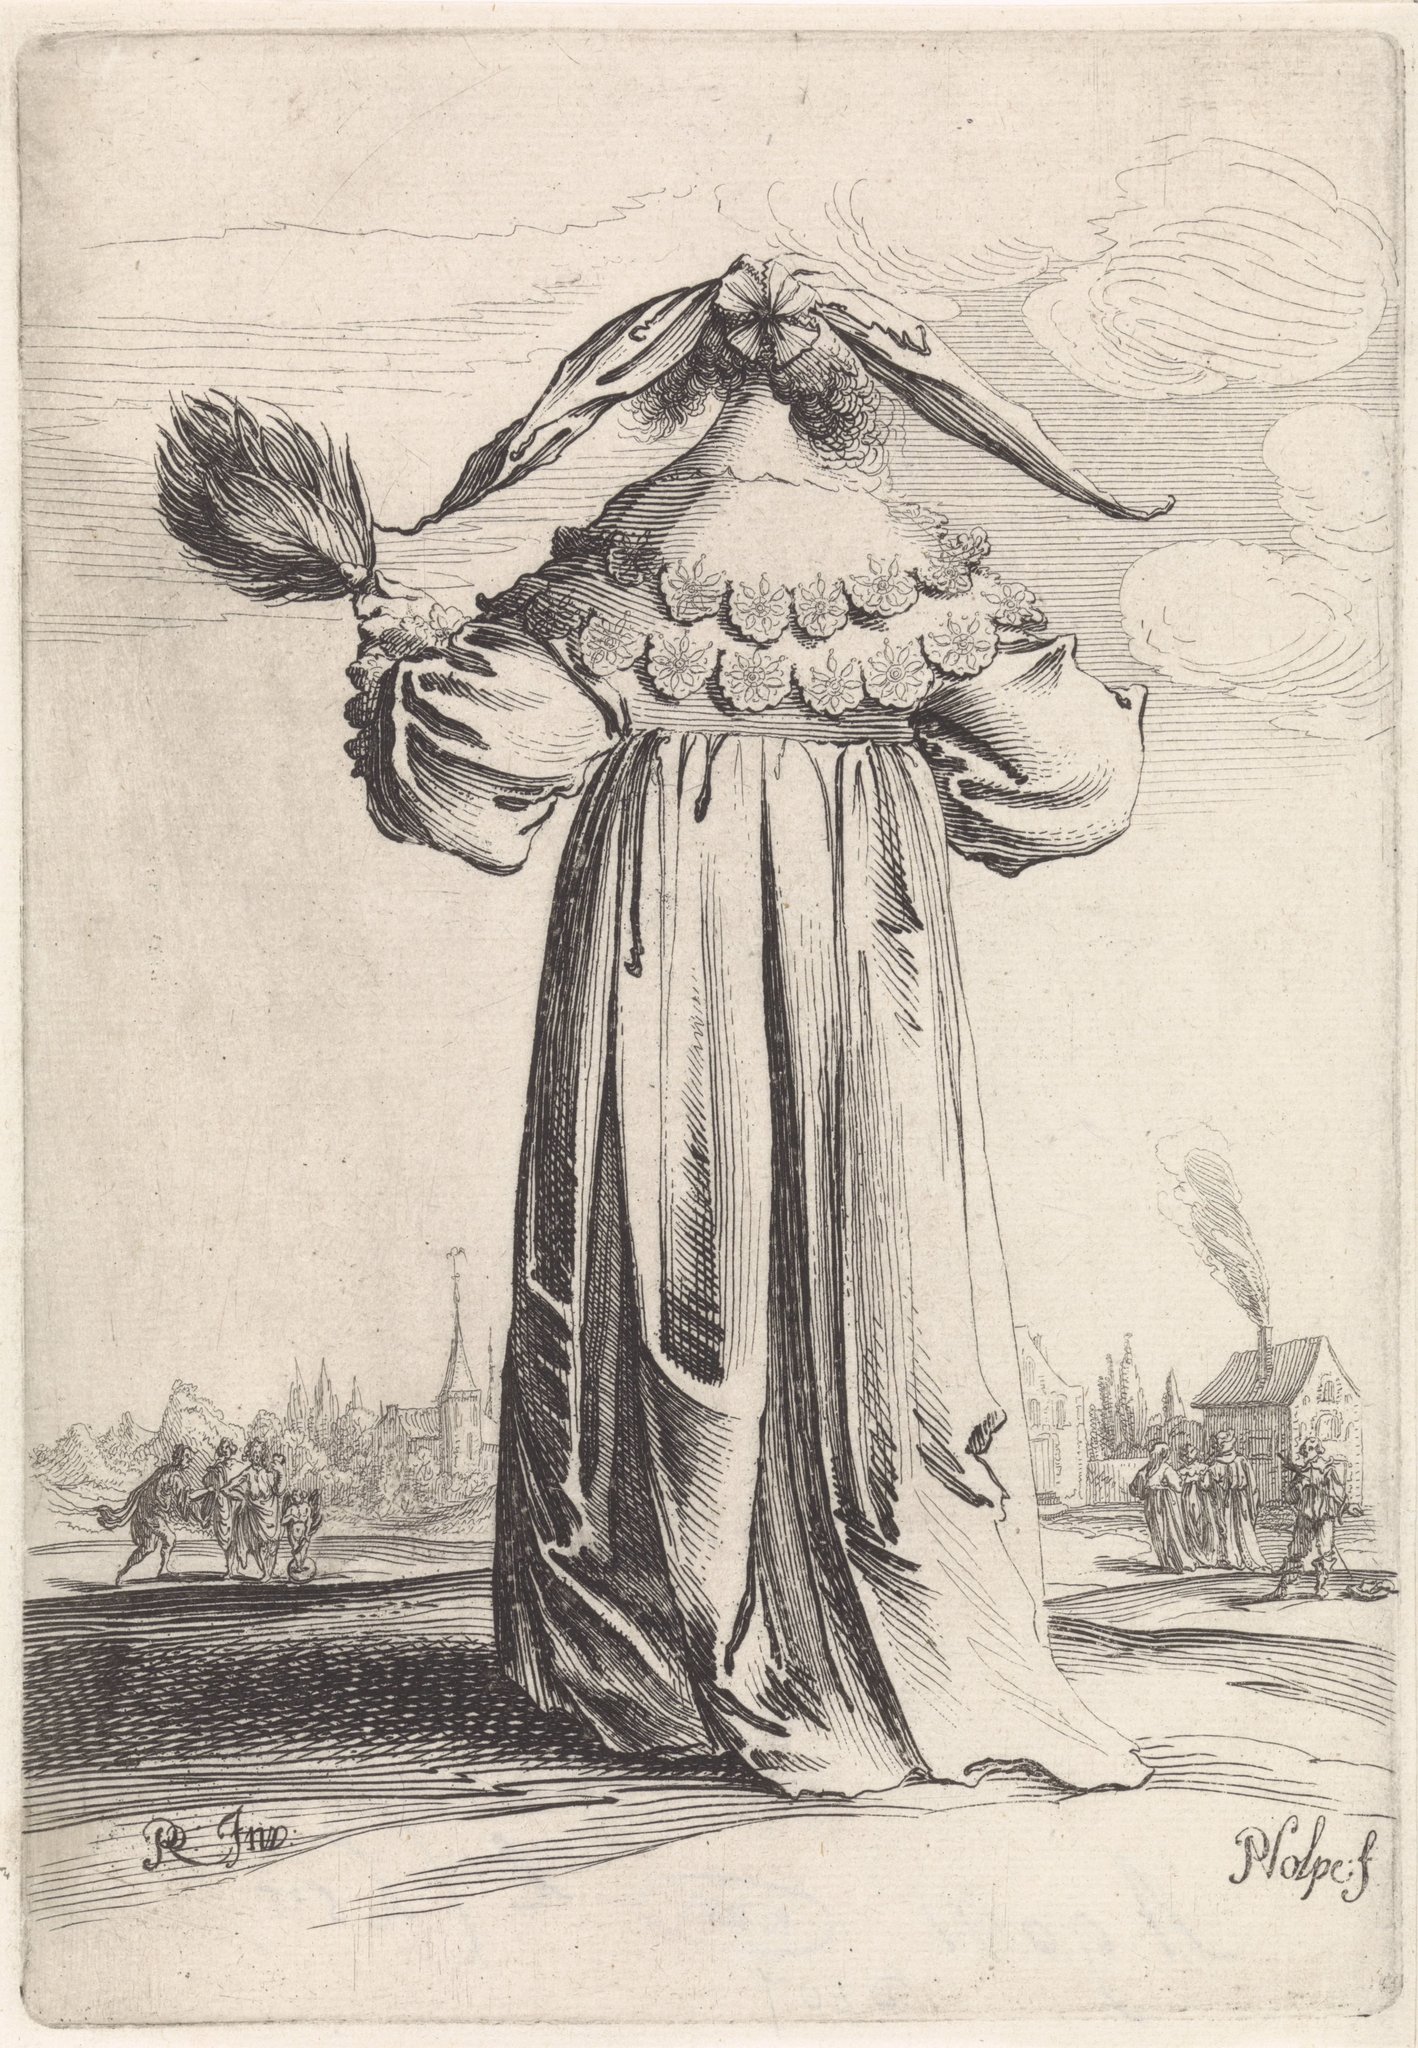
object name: costume print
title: Vrouw op de rug gezien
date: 1623-1653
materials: paper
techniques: engraving, etching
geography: amsterdam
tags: veil (+ women's clothes), neck-gear: collar (+ women's clothes), clothes, costume (+ women's clothes), dress, gown (+ women's clothes), fan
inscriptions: collector's mark: Lugt 2228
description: Een staande vrouw, op de rug gezien, houdt in de linkerhand een veren stokwaaier. Zij is gekleed in een lange japon met een dubbele platte kantenkraag. Haar kapsel is van achteren met een rozet versierd en de punten van de hoofddoek steken uit. Prent is deel van een serie van verschillende dames en herenkostuums.